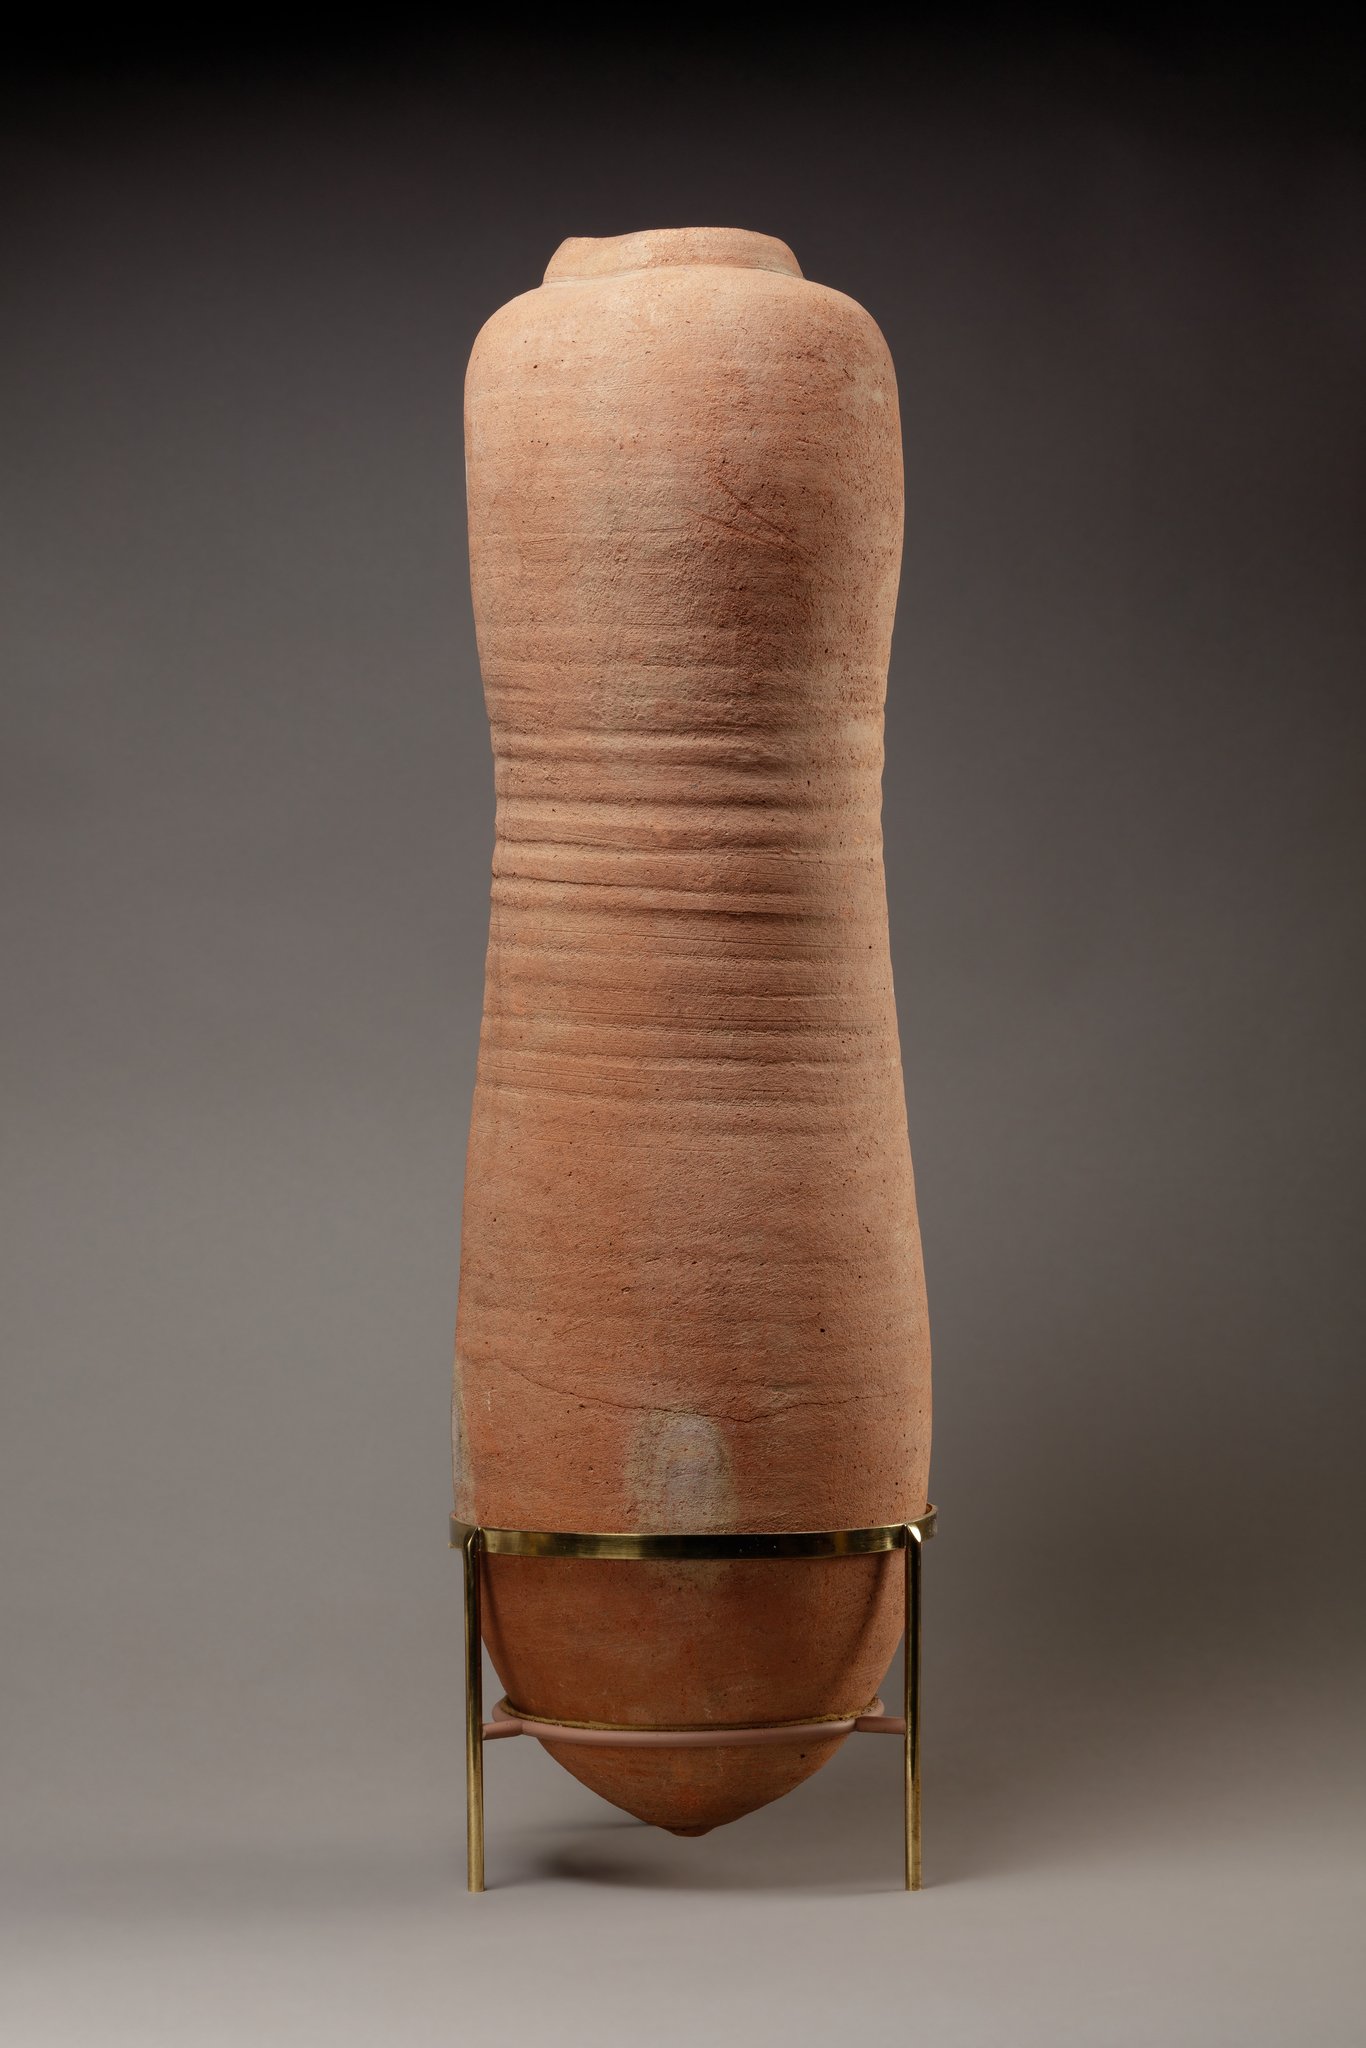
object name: vase, tall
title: Pot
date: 664-332 BCE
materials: pottery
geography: egypt